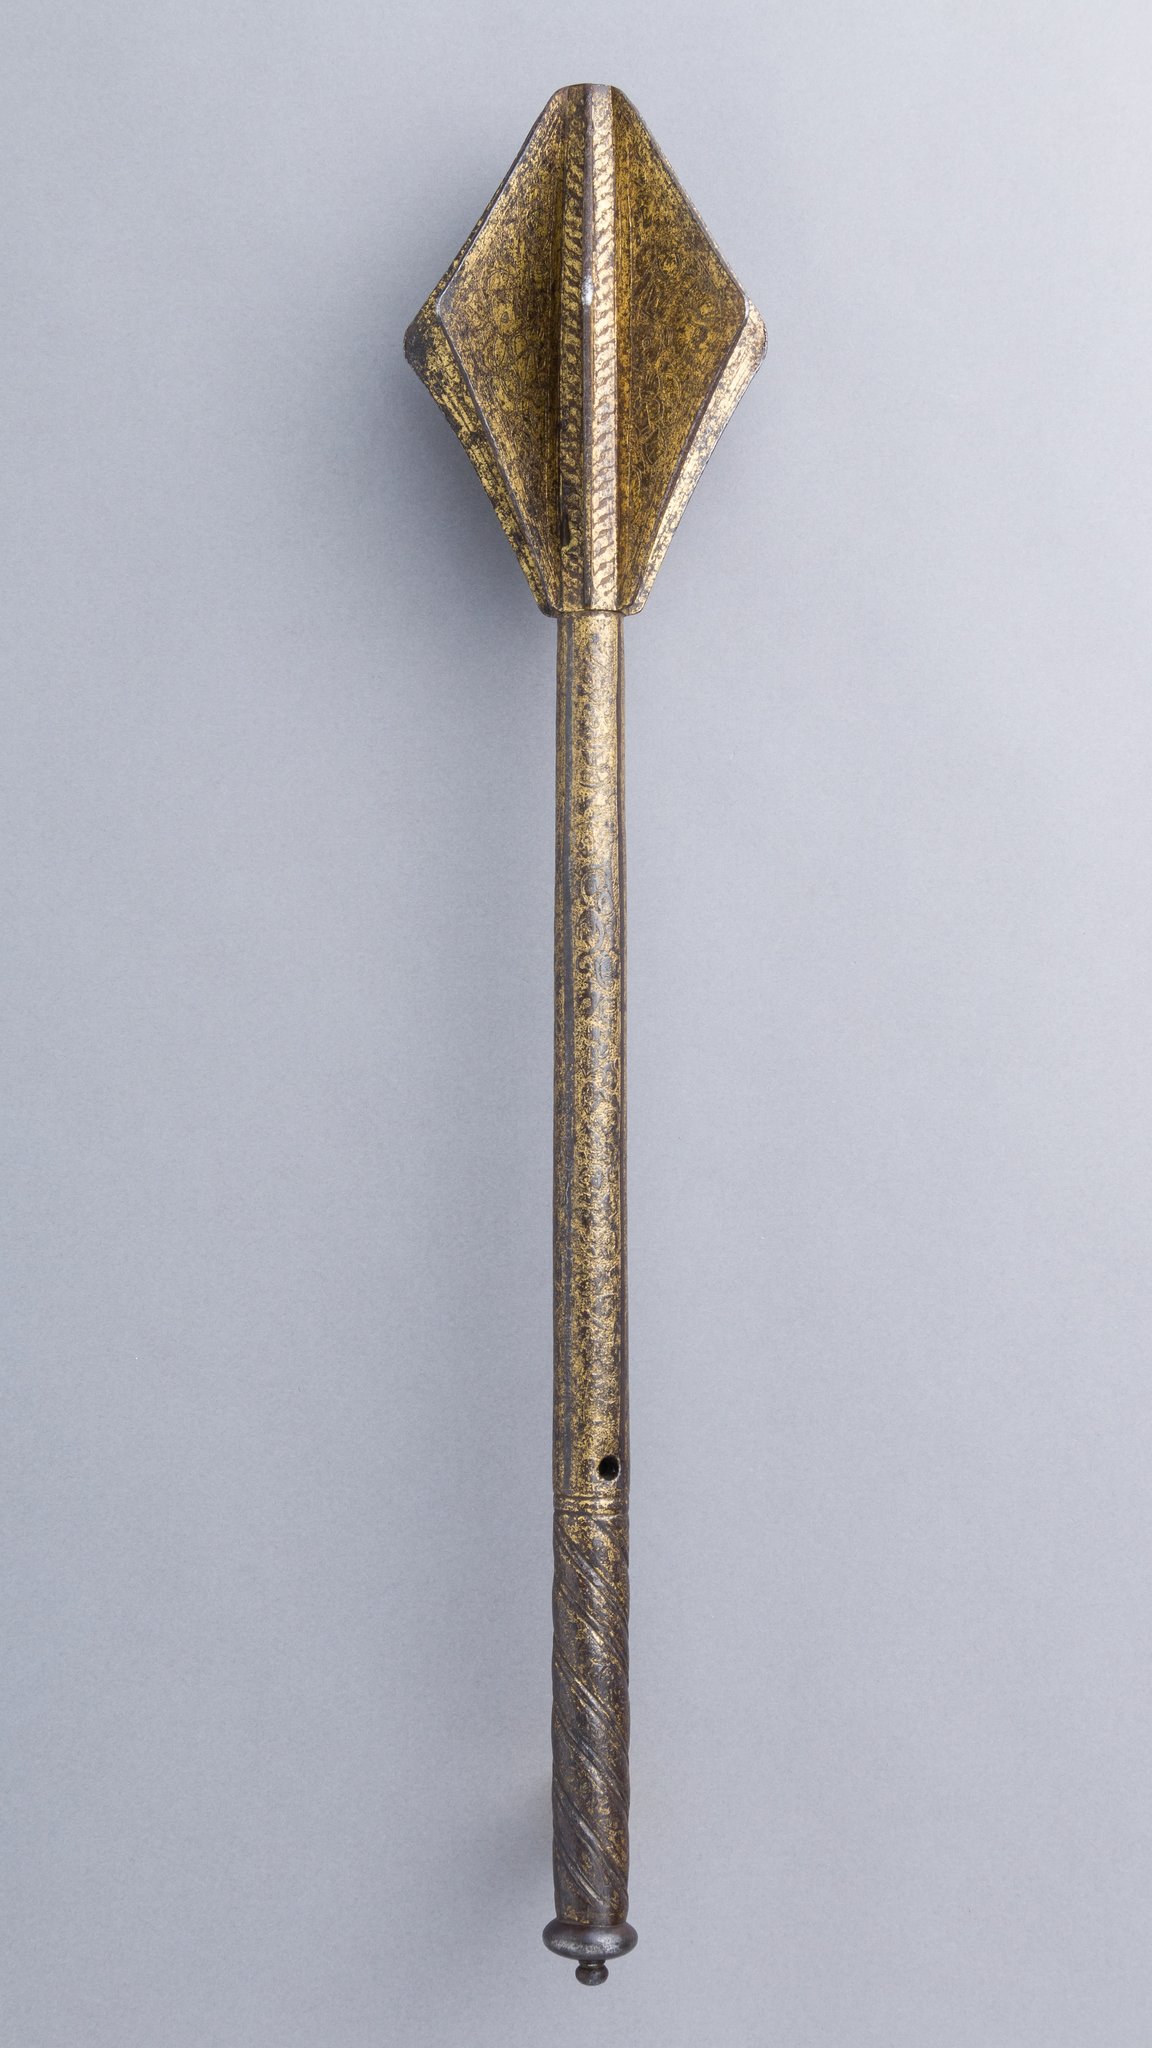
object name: mace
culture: italian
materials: gold, steel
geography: italy